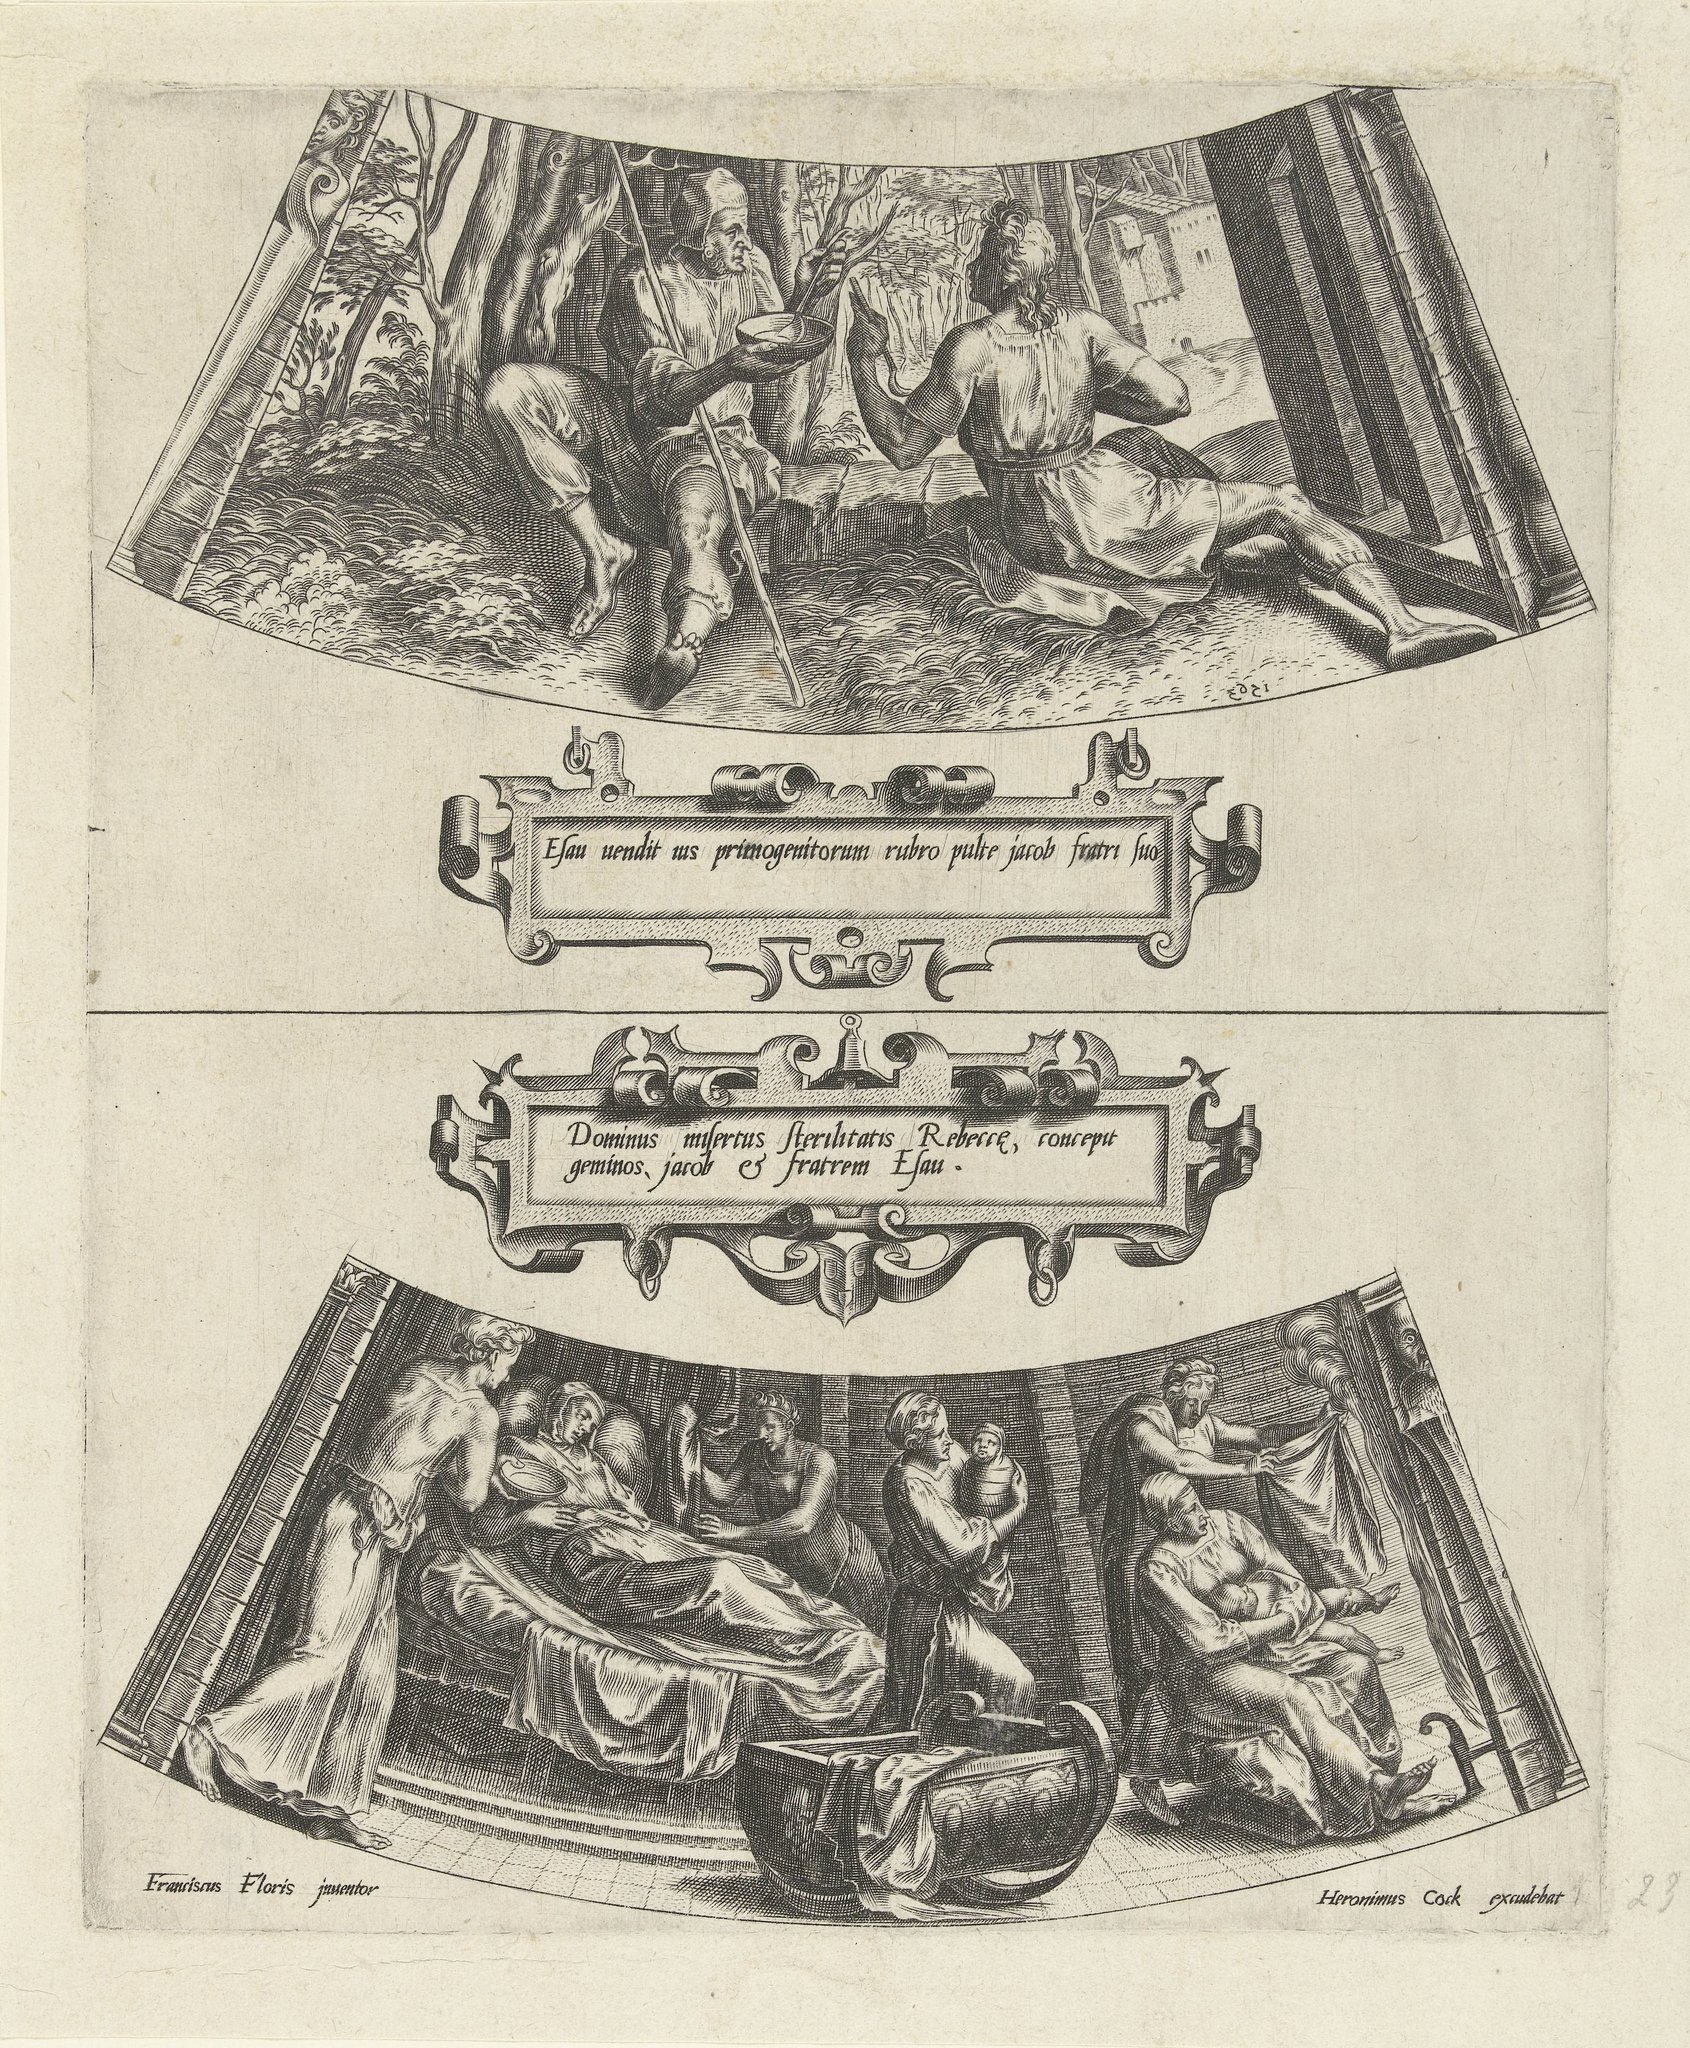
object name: print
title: De geschiedenis van Jakob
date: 1563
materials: paper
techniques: engraving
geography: antwerp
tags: ornament ~ cartouche, cradle, crib, esau, returning hungry from the hunt, sells his first birthright to jacob for a pottage of lentils, birth of the twins: jacob clutches esau's heel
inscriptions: date: ‘1563’, caption: ‘Esau vendit ius primogenitorum rubro pulte jacob fratri suo.’, signature: ‘Franciscus Floris inventor’, address: ‘Hieronimus Cock excudebat’, caption: ‘Dominus misertus sterilitatis Rebeccae, concepit / geminos, jacob et fratrem Esau’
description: Ornamen voor schotelrand. Bovenste helft: Jakob en Esau zitten voor een huis op de grond. Esau eet het bord linzensoep en verkoopt daarmee zijn eerstgeboorterecht. Onderste helft: de geboorte van Esau en Jakob. Rebekka ligt in het kraambed. Rechts de vroedvrouwen met de ingebakerde baby's. Op de voorgrond een schommelwieg. Met Latijnse tekst in cartouches.